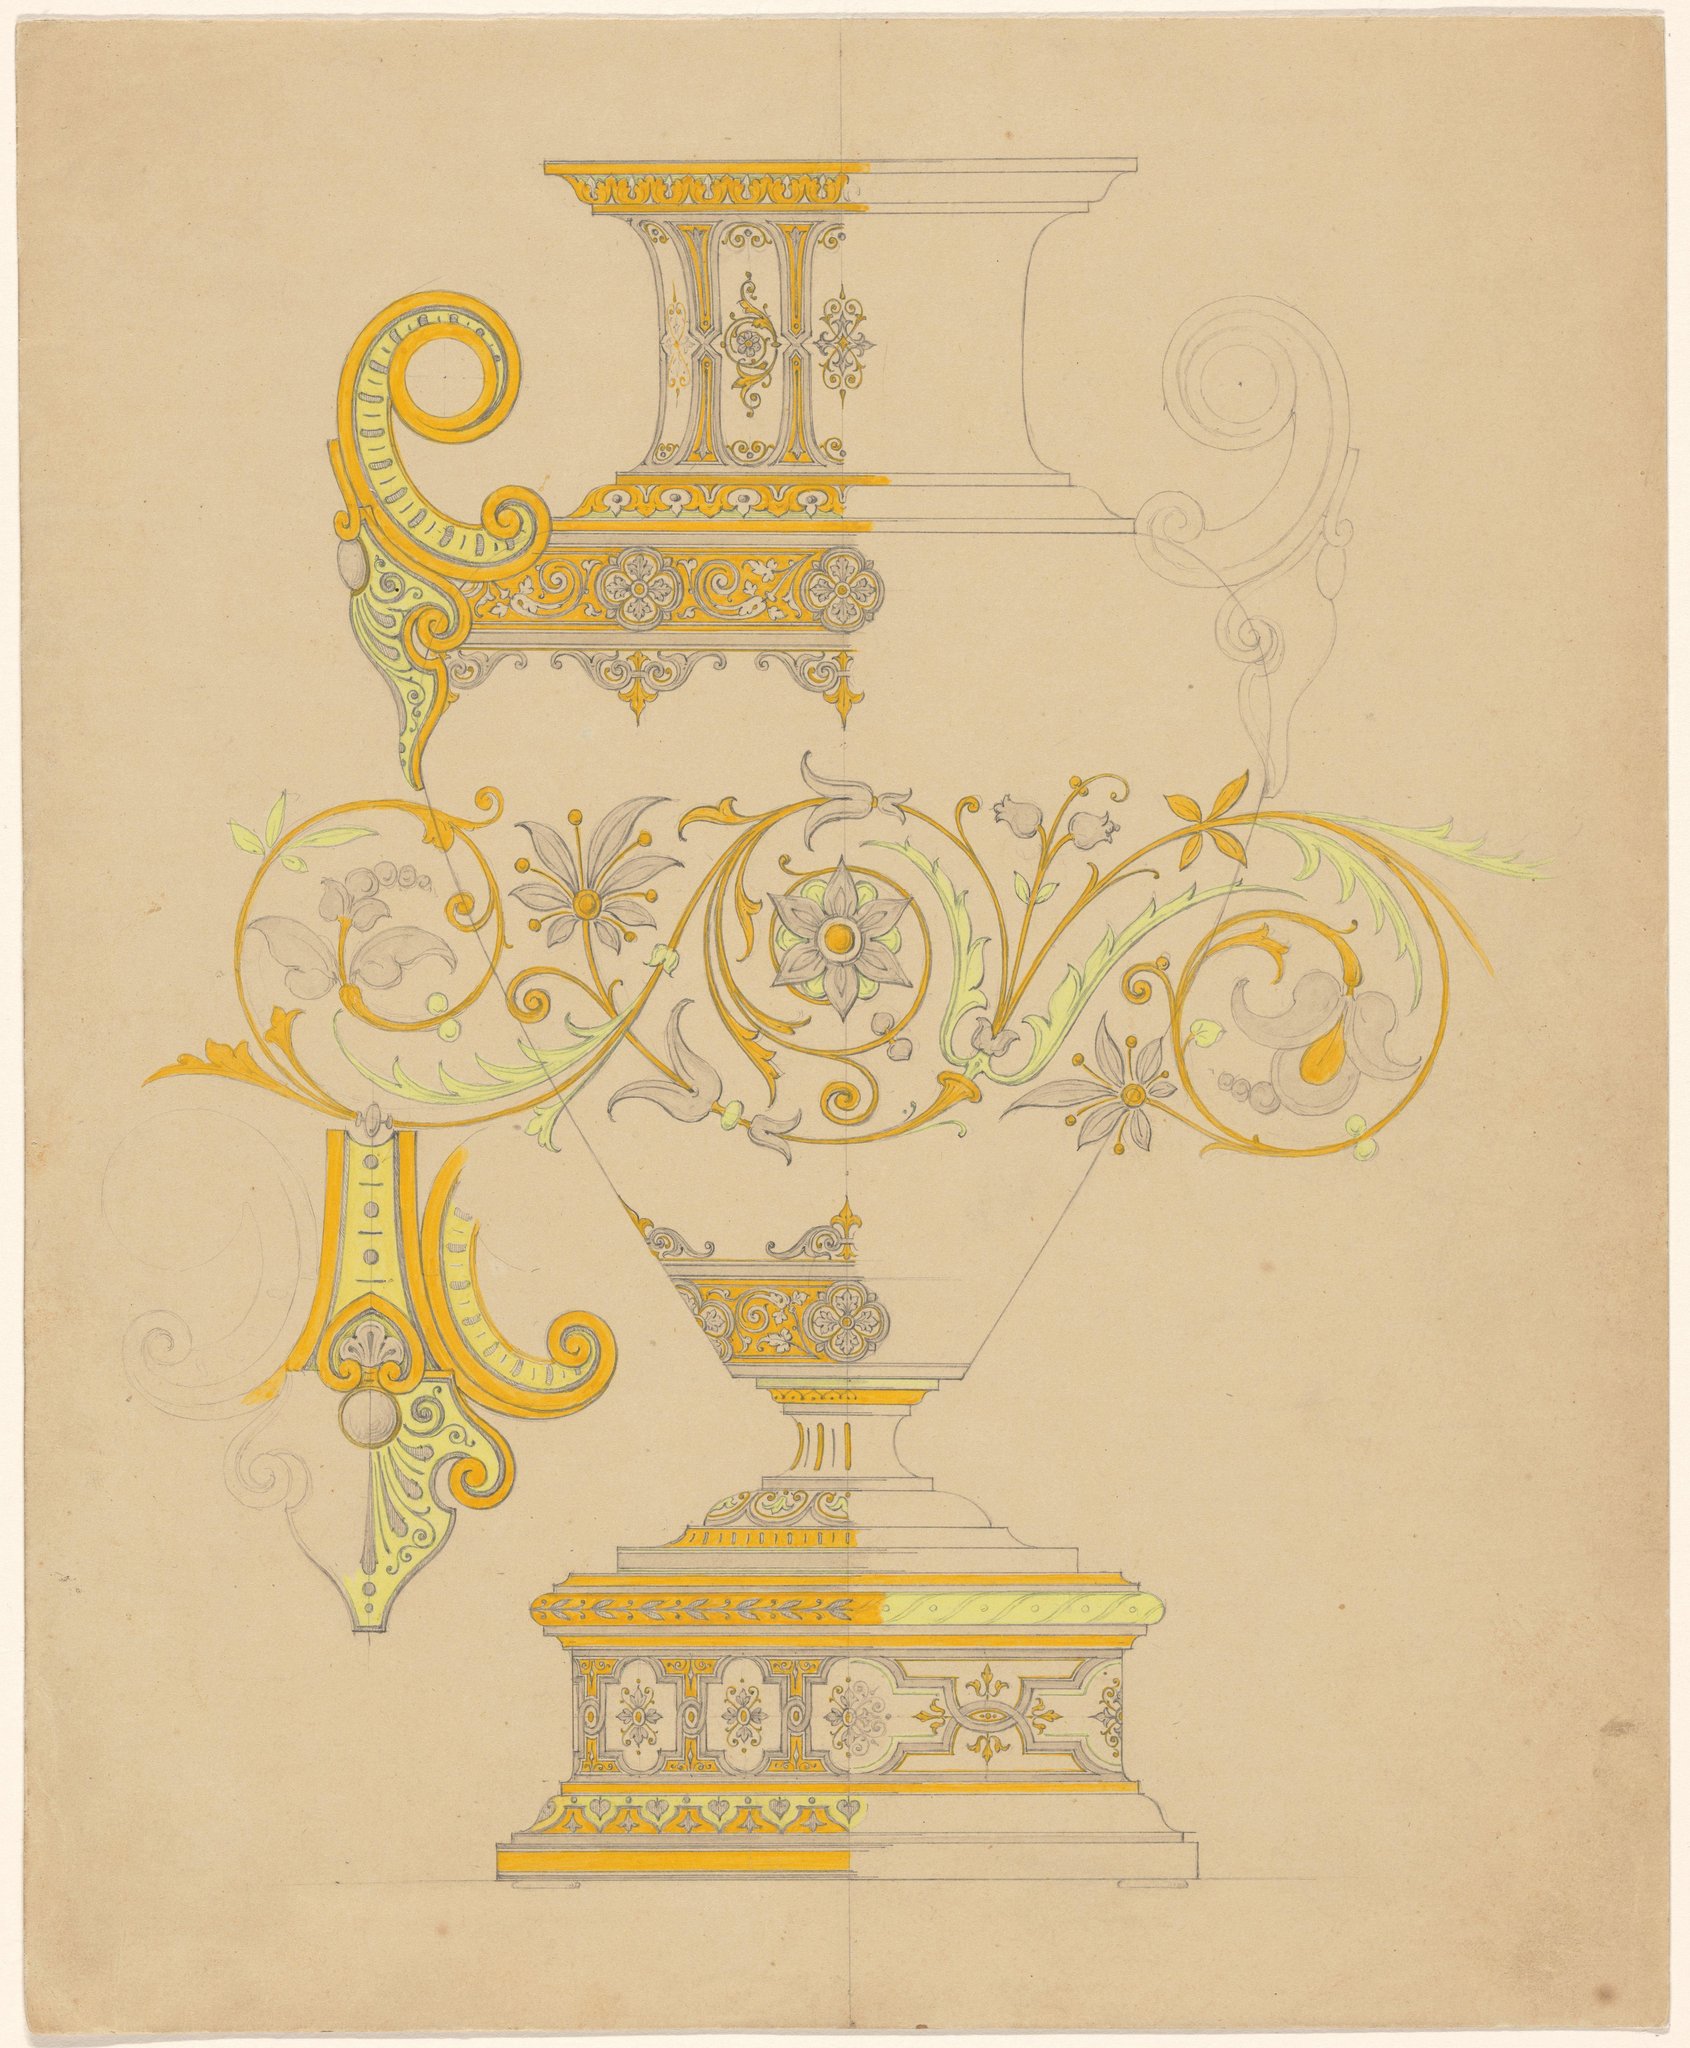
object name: design drawing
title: Gedamascineerd ijzeren vaas, waarvan alleen de linkerzijde is ingevuld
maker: plácido zuloaga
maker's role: sculptor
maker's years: 1833-1910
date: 1870-1880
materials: graphite, paper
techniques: brush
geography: eibar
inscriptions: inscription: ‘Carpeta XVIII / No. 2.465’